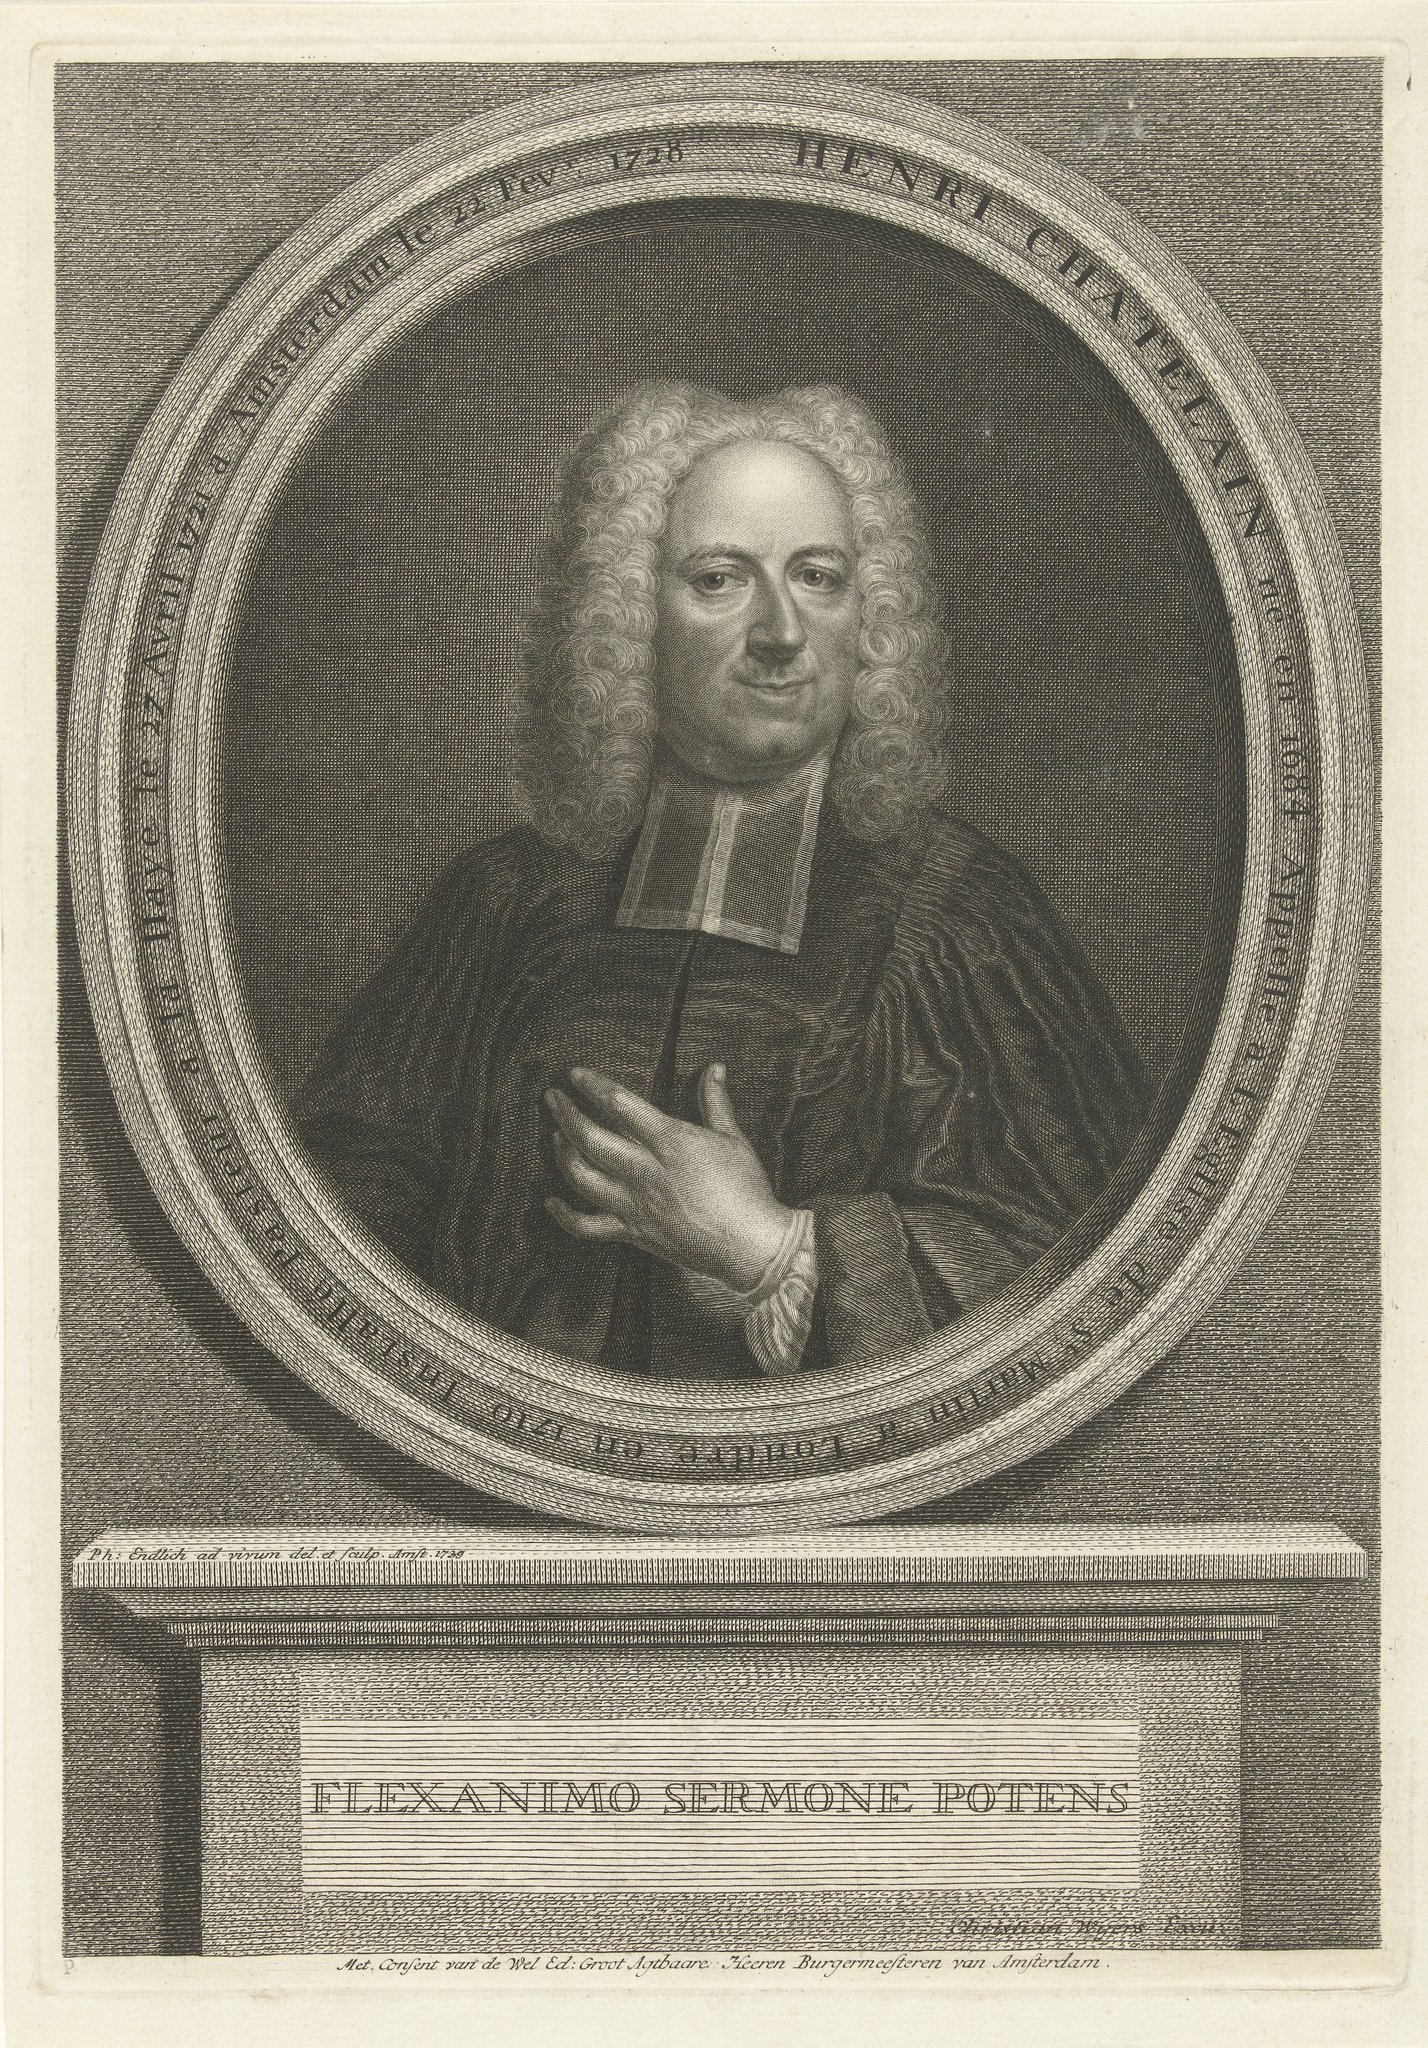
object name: print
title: Portret van Henri Chatelain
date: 1739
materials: paper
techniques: engraving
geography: amsterdam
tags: paris, amsterdam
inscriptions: collector's mark: Lugt 2228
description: Portret van de Franse cartograaf Henri Abraham Châtelain (1684-1743), met hand op de borst. Afgebeeld in ovale omlijsting met Franse tekst. Onder de lijst een console met opschrift in Latijn.